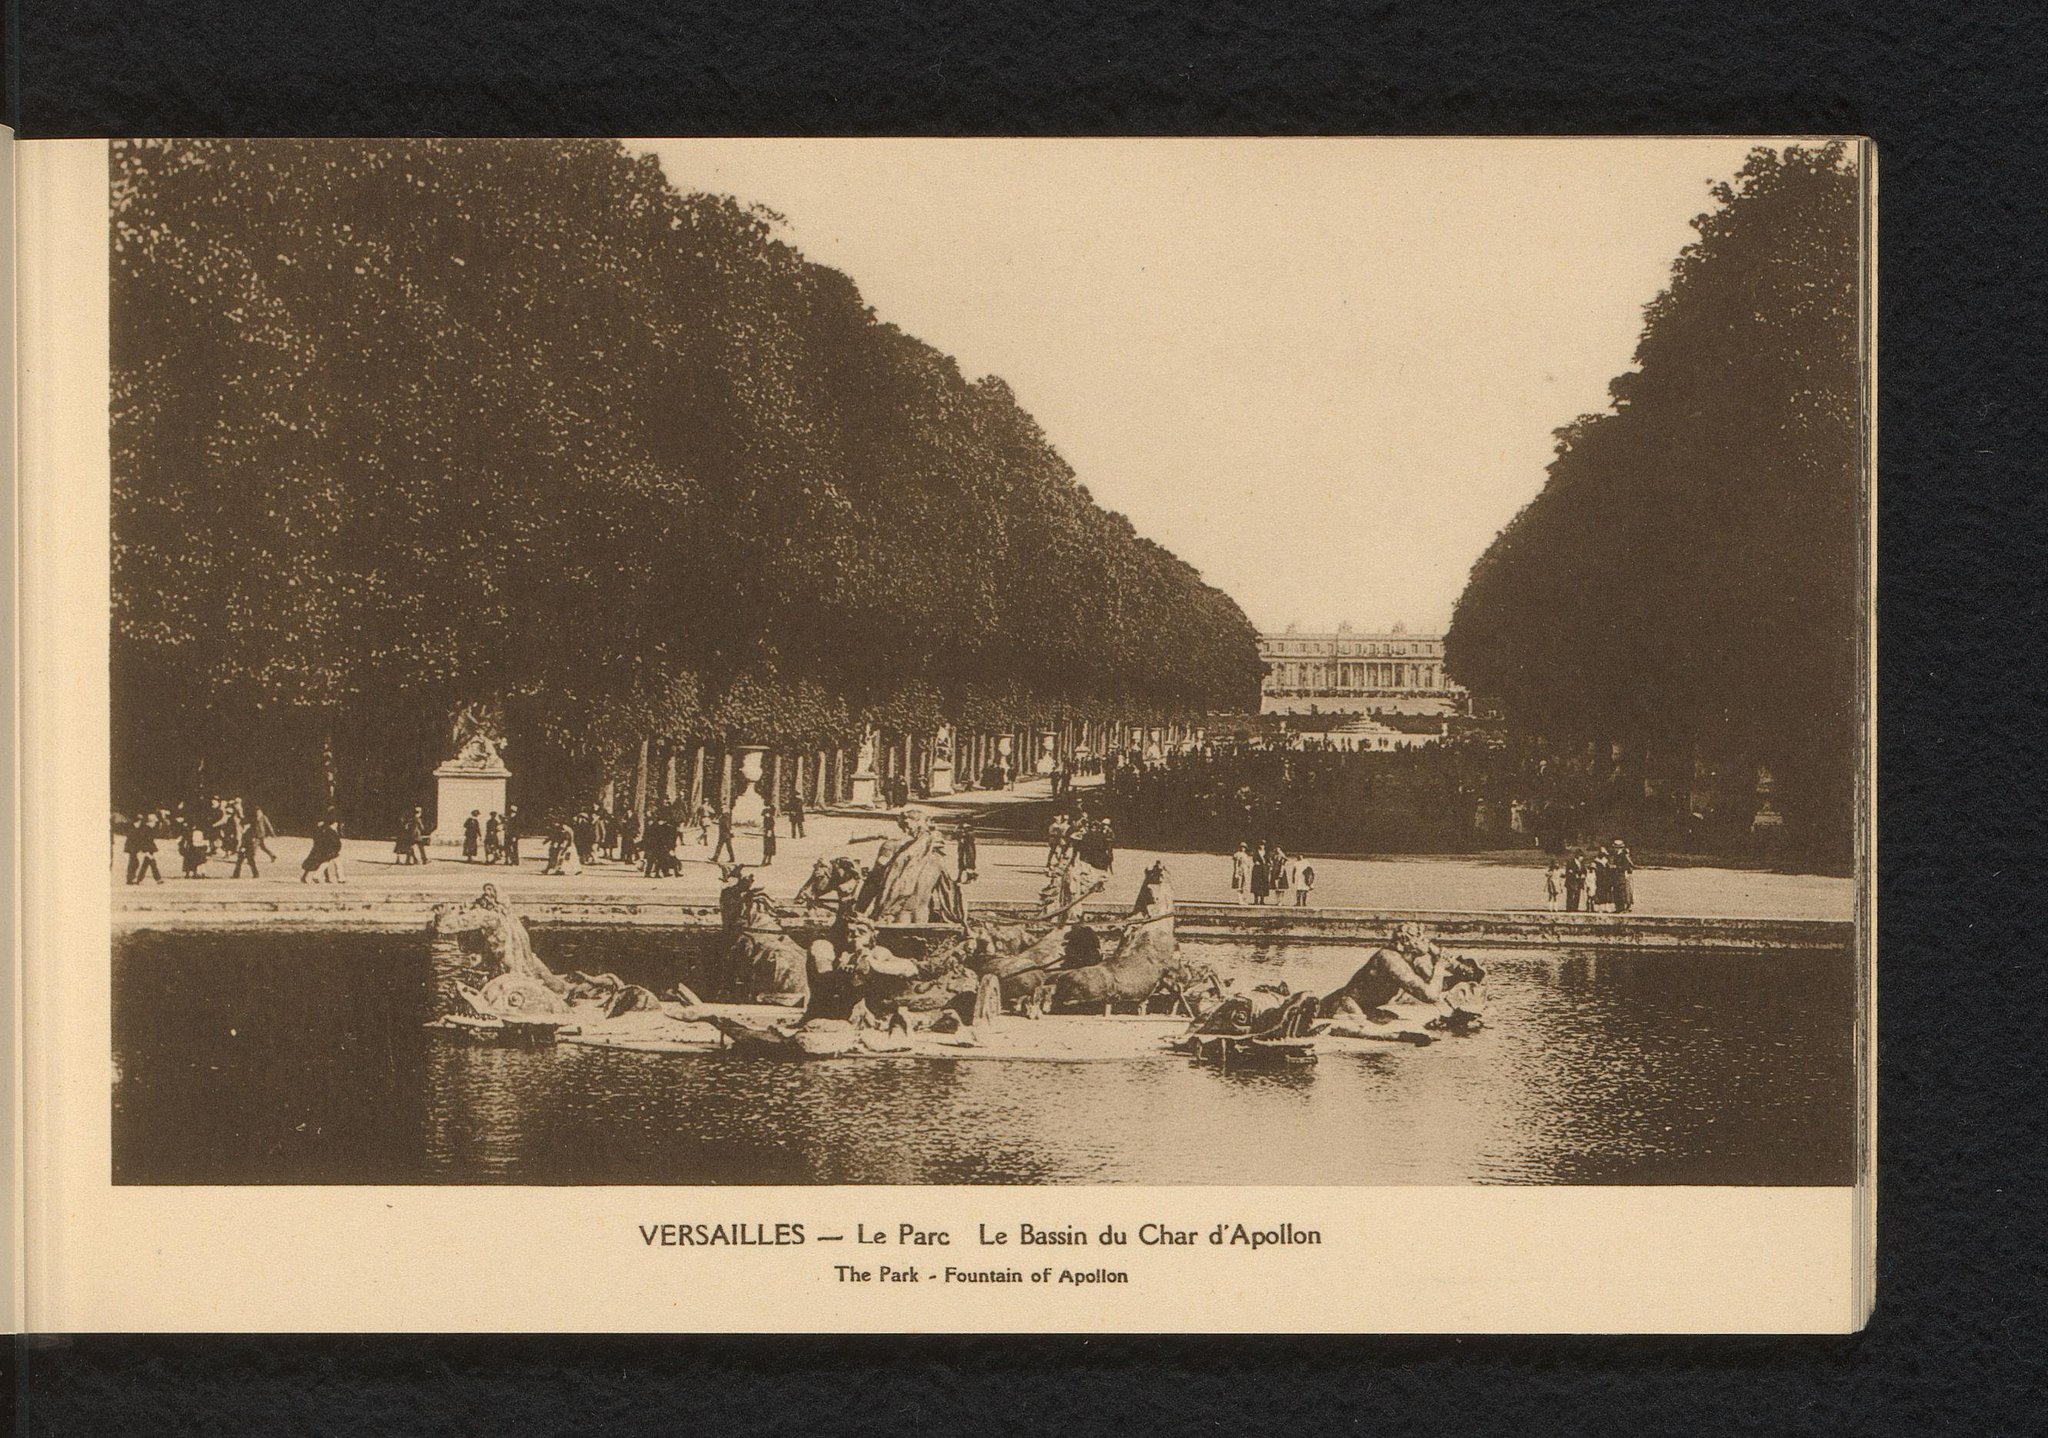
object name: photomechanical print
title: Versailles. Le Parc. Le Bassin du Char d'Apollon / The Park. Fountain of Apollon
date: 1919-1930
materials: cardboard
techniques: photograph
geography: paris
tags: french or architectonic garden; formal garden, water-works in garden